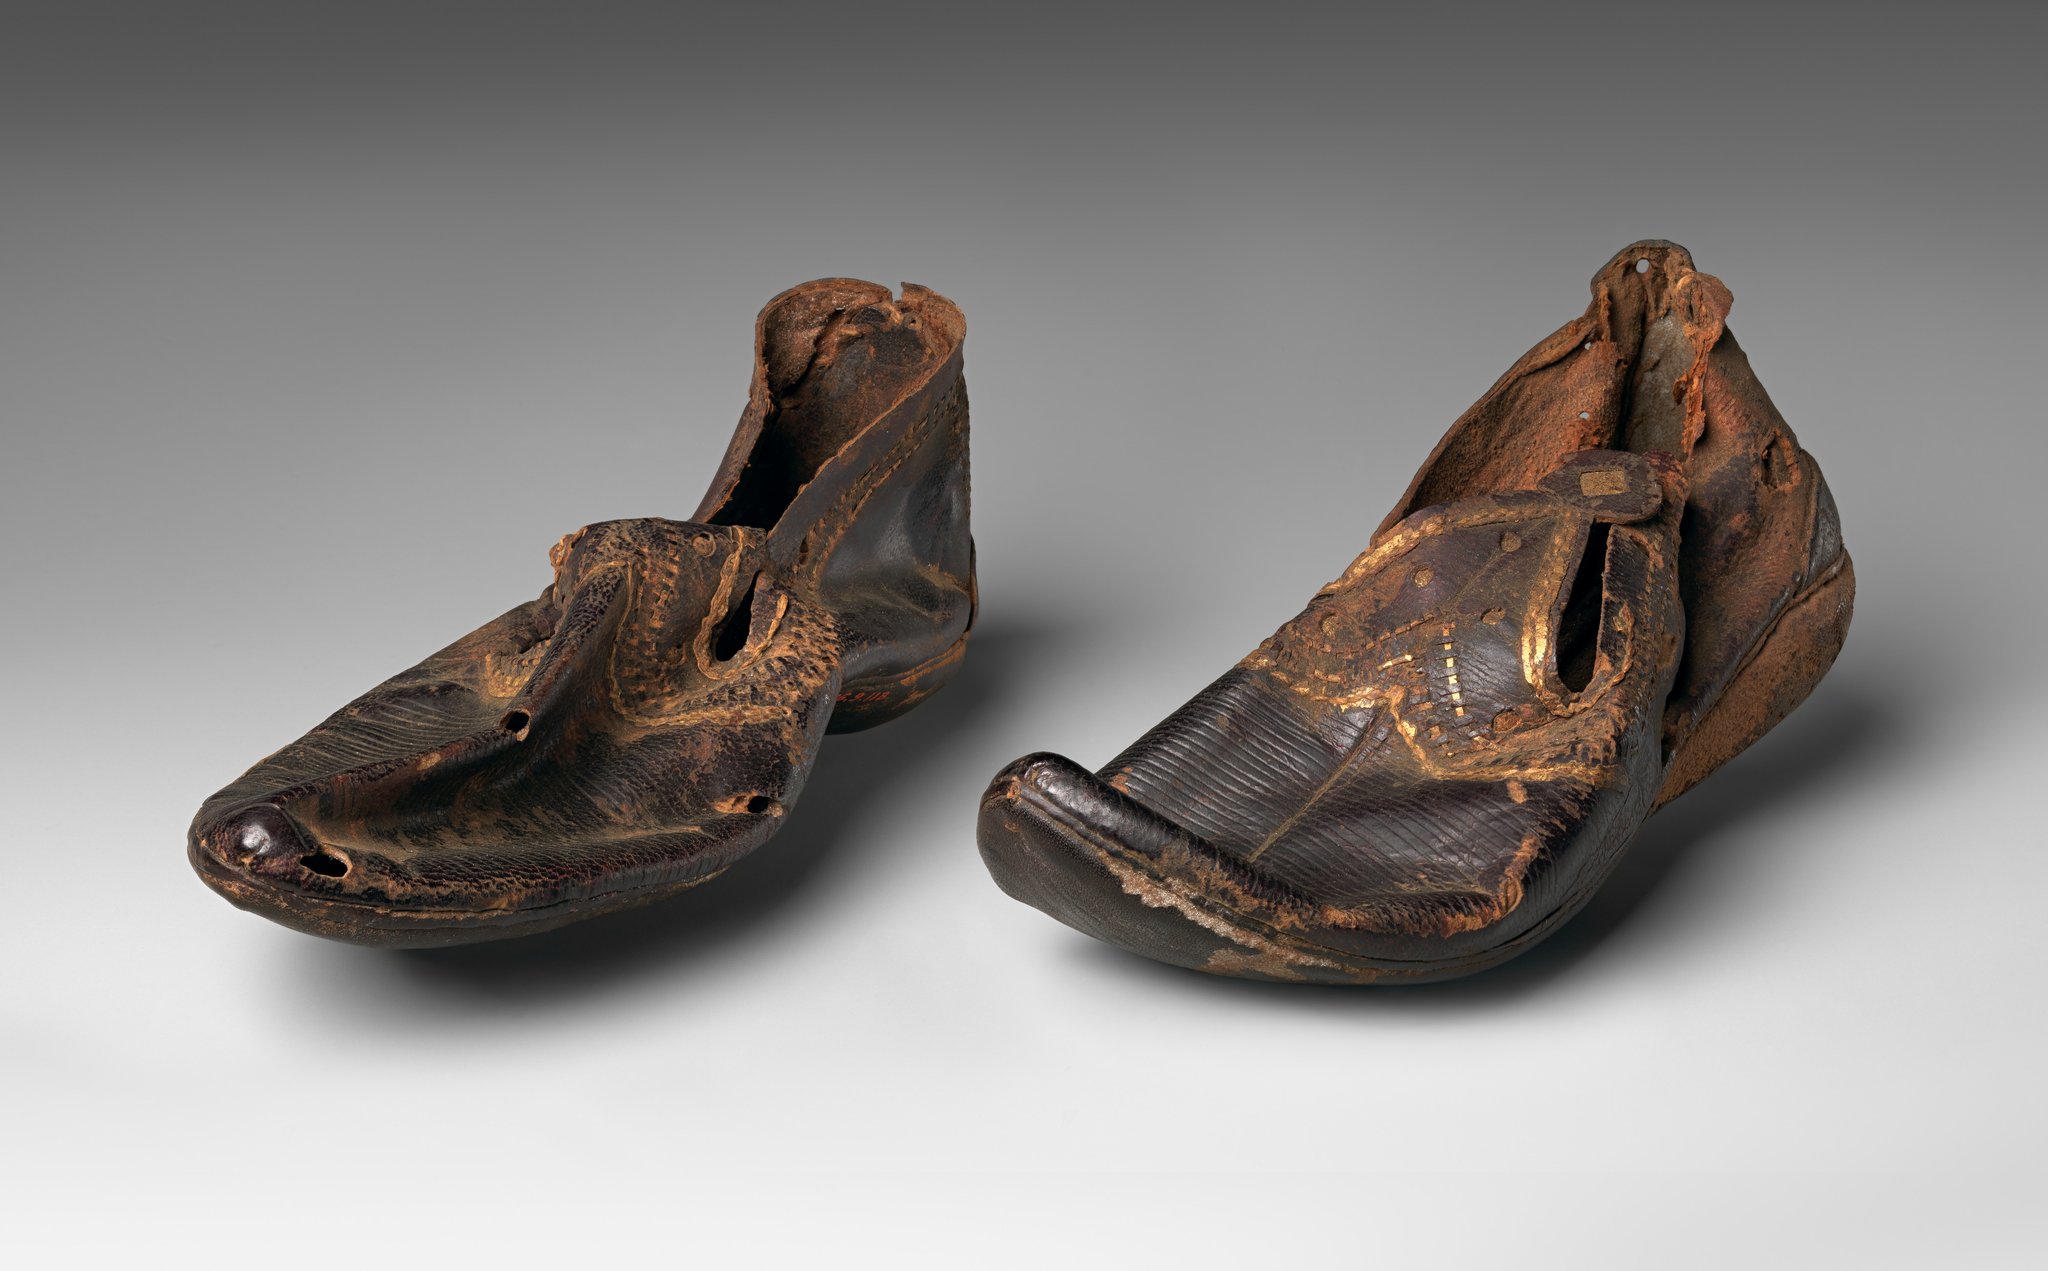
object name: shoe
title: Pair of Shoes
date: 201-900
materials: leather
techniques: gilding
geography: egypt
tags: shoes